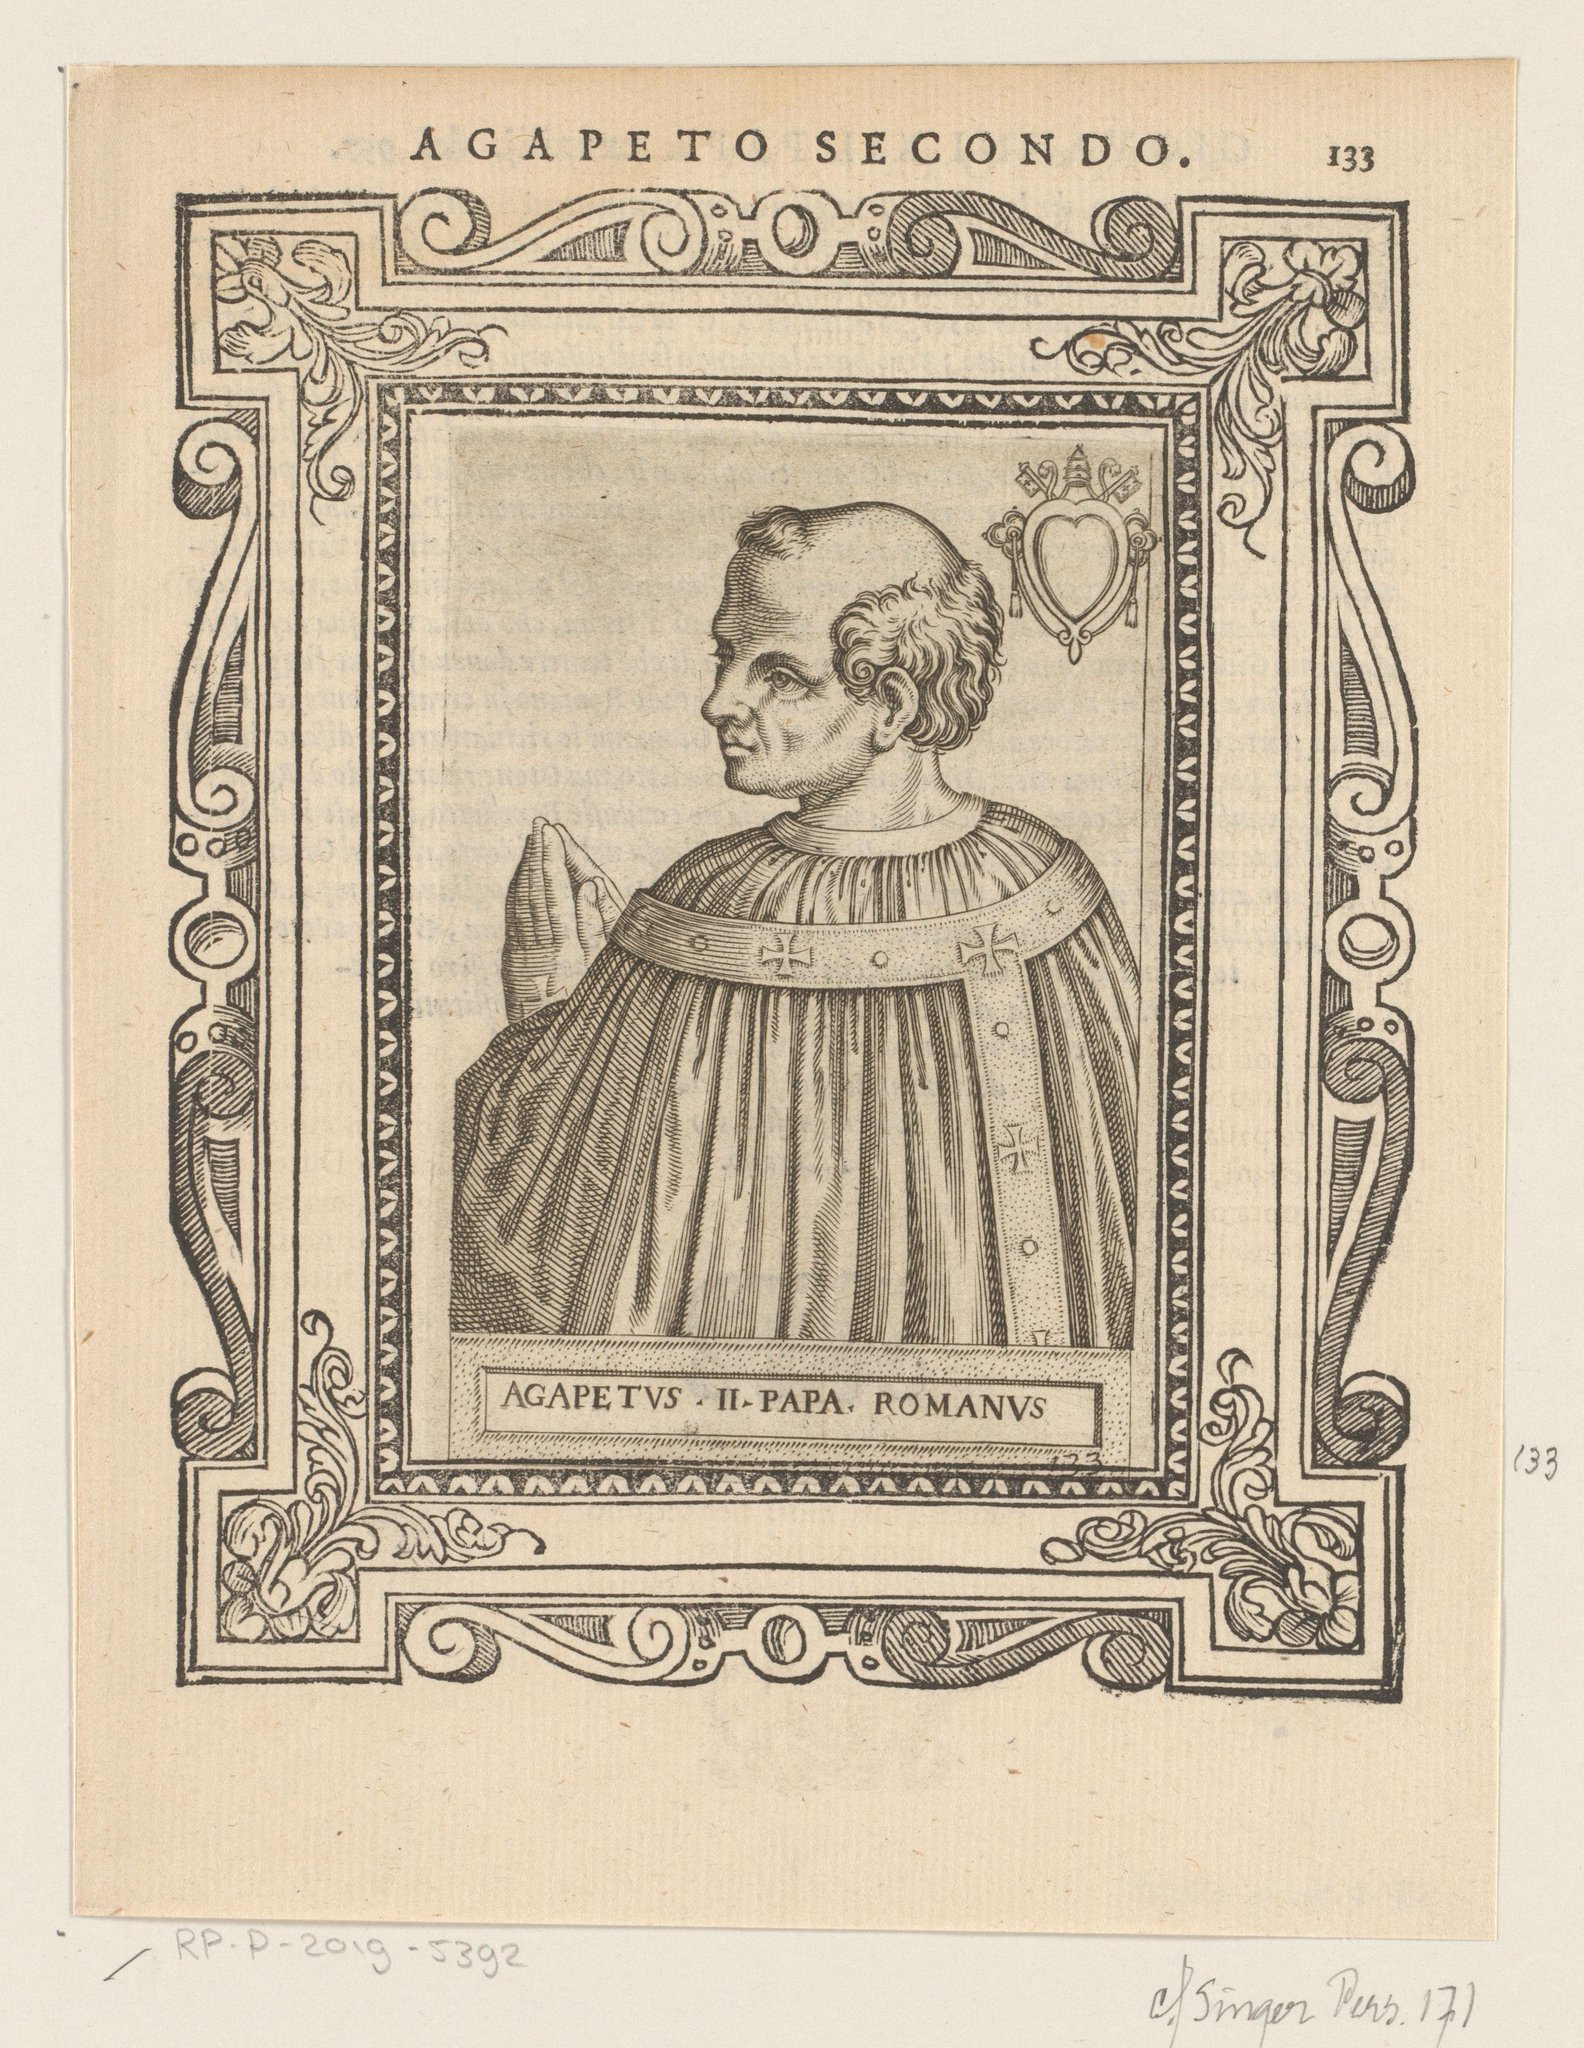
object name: print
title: Agapetus II Papa Romanus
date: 1587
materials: paper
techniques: engraving, letterpress printing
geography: rome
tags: historical persons, pope, armorial bearing, heraldry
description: Prent uit: Ciccarelli, Antonio. Le vite de Pontefici di Antonio Ciccarelli (...). Rome: Domenico Basa, 1587. Prent voor het eerst verschenen in: Cavalieri, Giovanni Battista de'. Pontificum romanorum effigies (...). Rome: Domenico Basa en Francesco Zanetti, 1580. Prent ook gebruikt in latere publicaties.